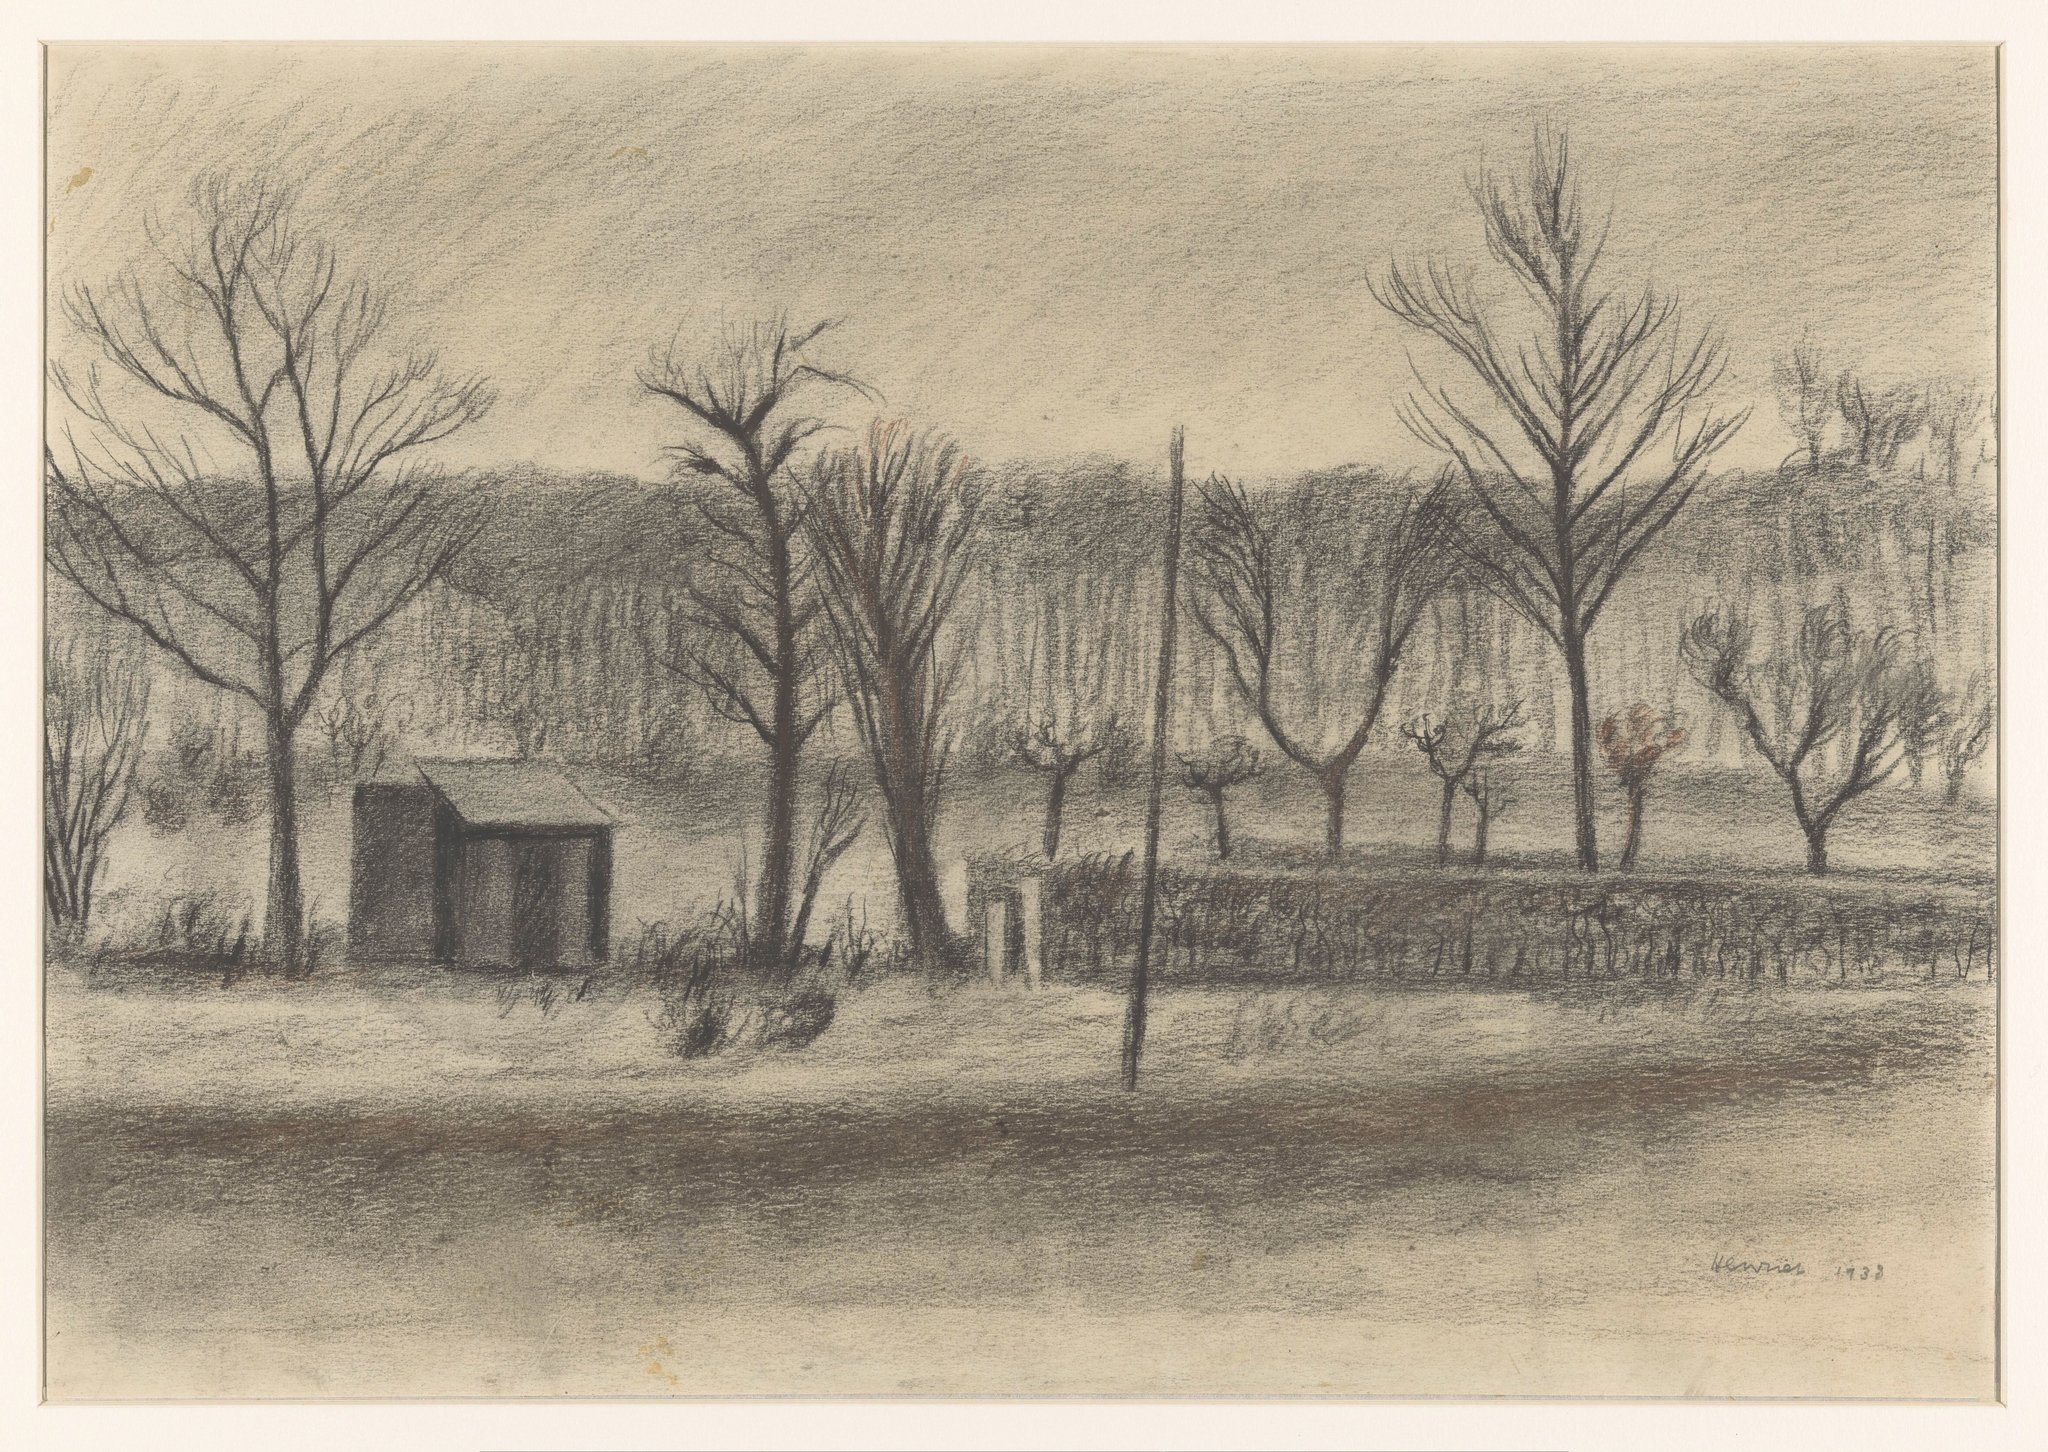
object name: drawing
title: Landschap met bomen en een schuur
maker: henk henriët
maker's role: draughtsman, print maker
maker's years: 1903-1945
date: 1933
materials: chalk, paper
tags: landscapes in the temperate zone, shed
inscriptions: collector's mark: Lugt 2228